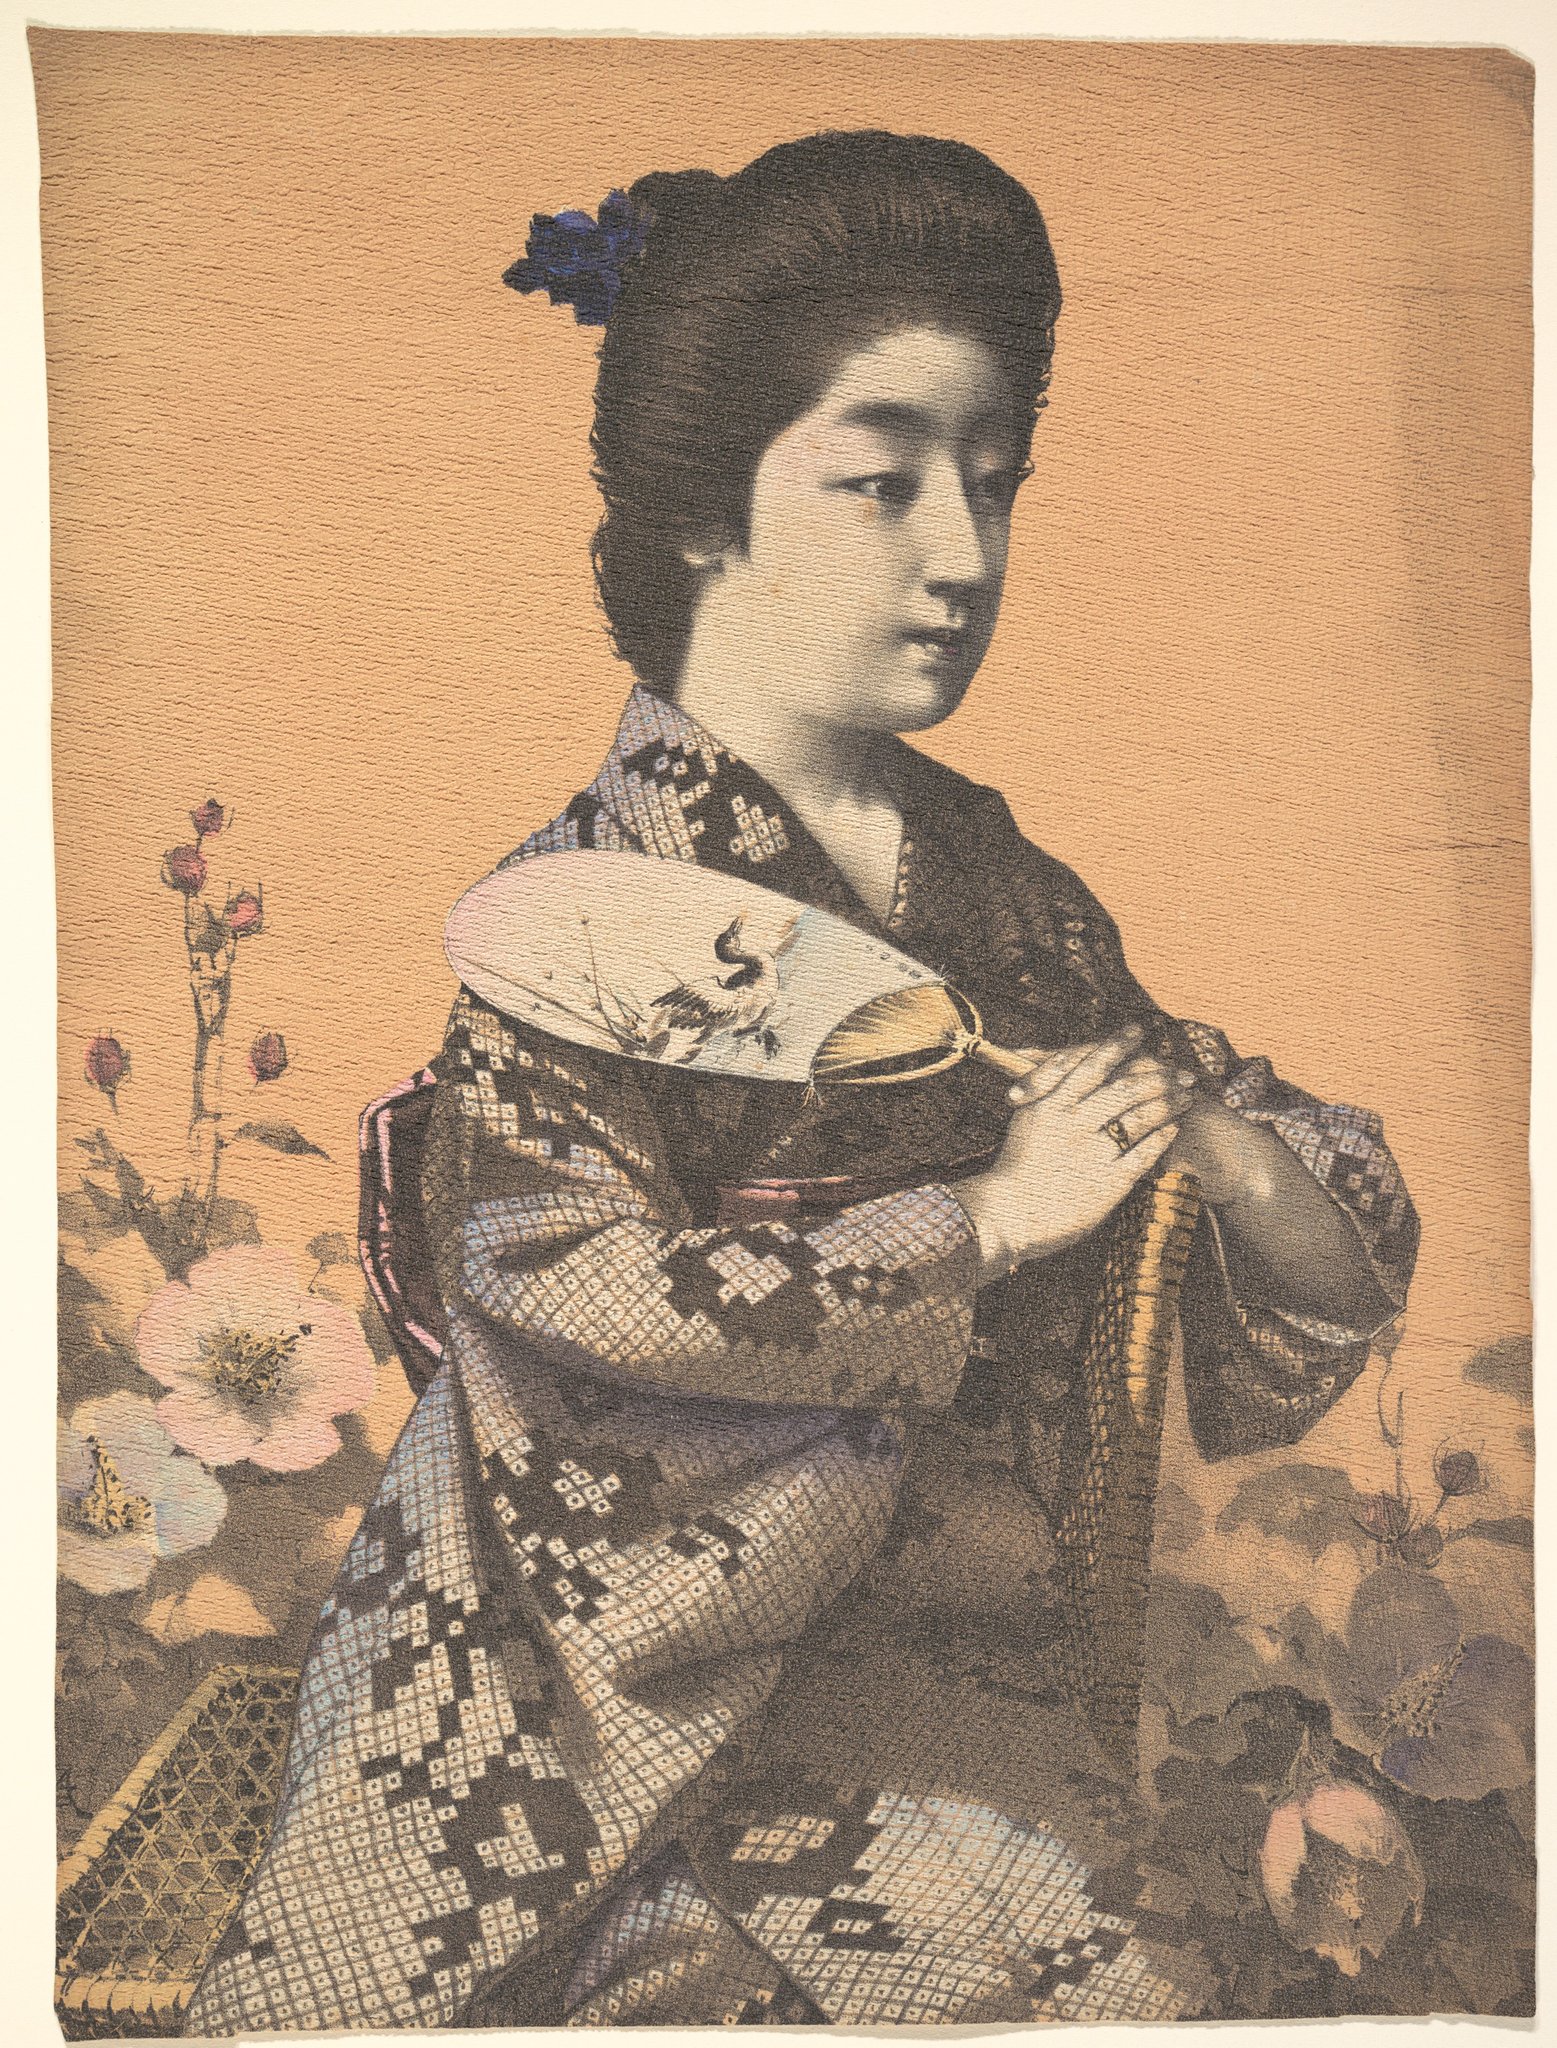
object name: print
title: Girl Carrying a Round Paper Fan (Uchiwa)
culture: japanese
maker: unidentified artist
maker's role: artist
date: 1900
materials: ink, paper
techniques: woodblock print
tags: birds,fans,girls,flowers